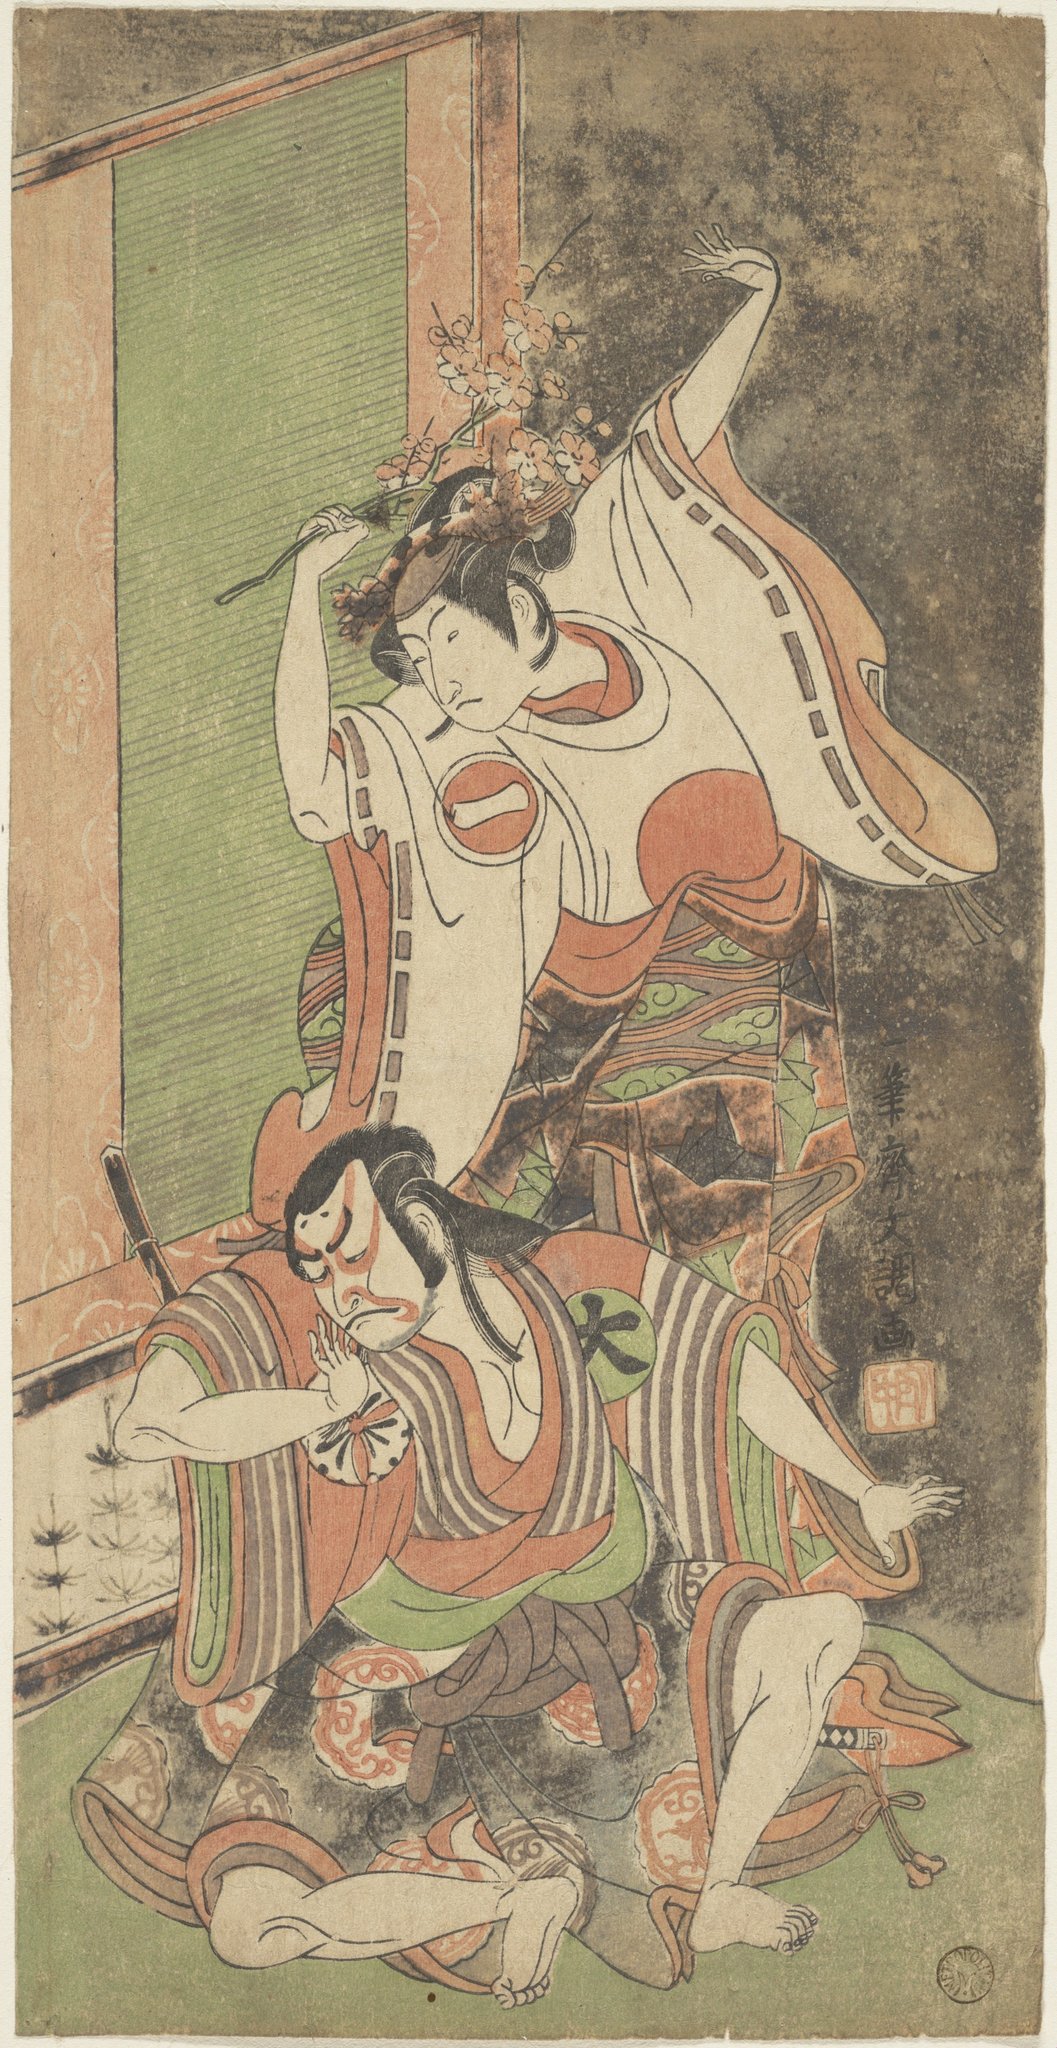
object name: print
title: Ichikawa Monnosuke II as a Woman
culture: japanese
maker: ippitsusai bunchō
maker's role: artist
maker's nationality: japanese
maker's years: 1765-1792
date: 1770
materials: ink, paper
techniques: woodblock print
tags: men,women,actors